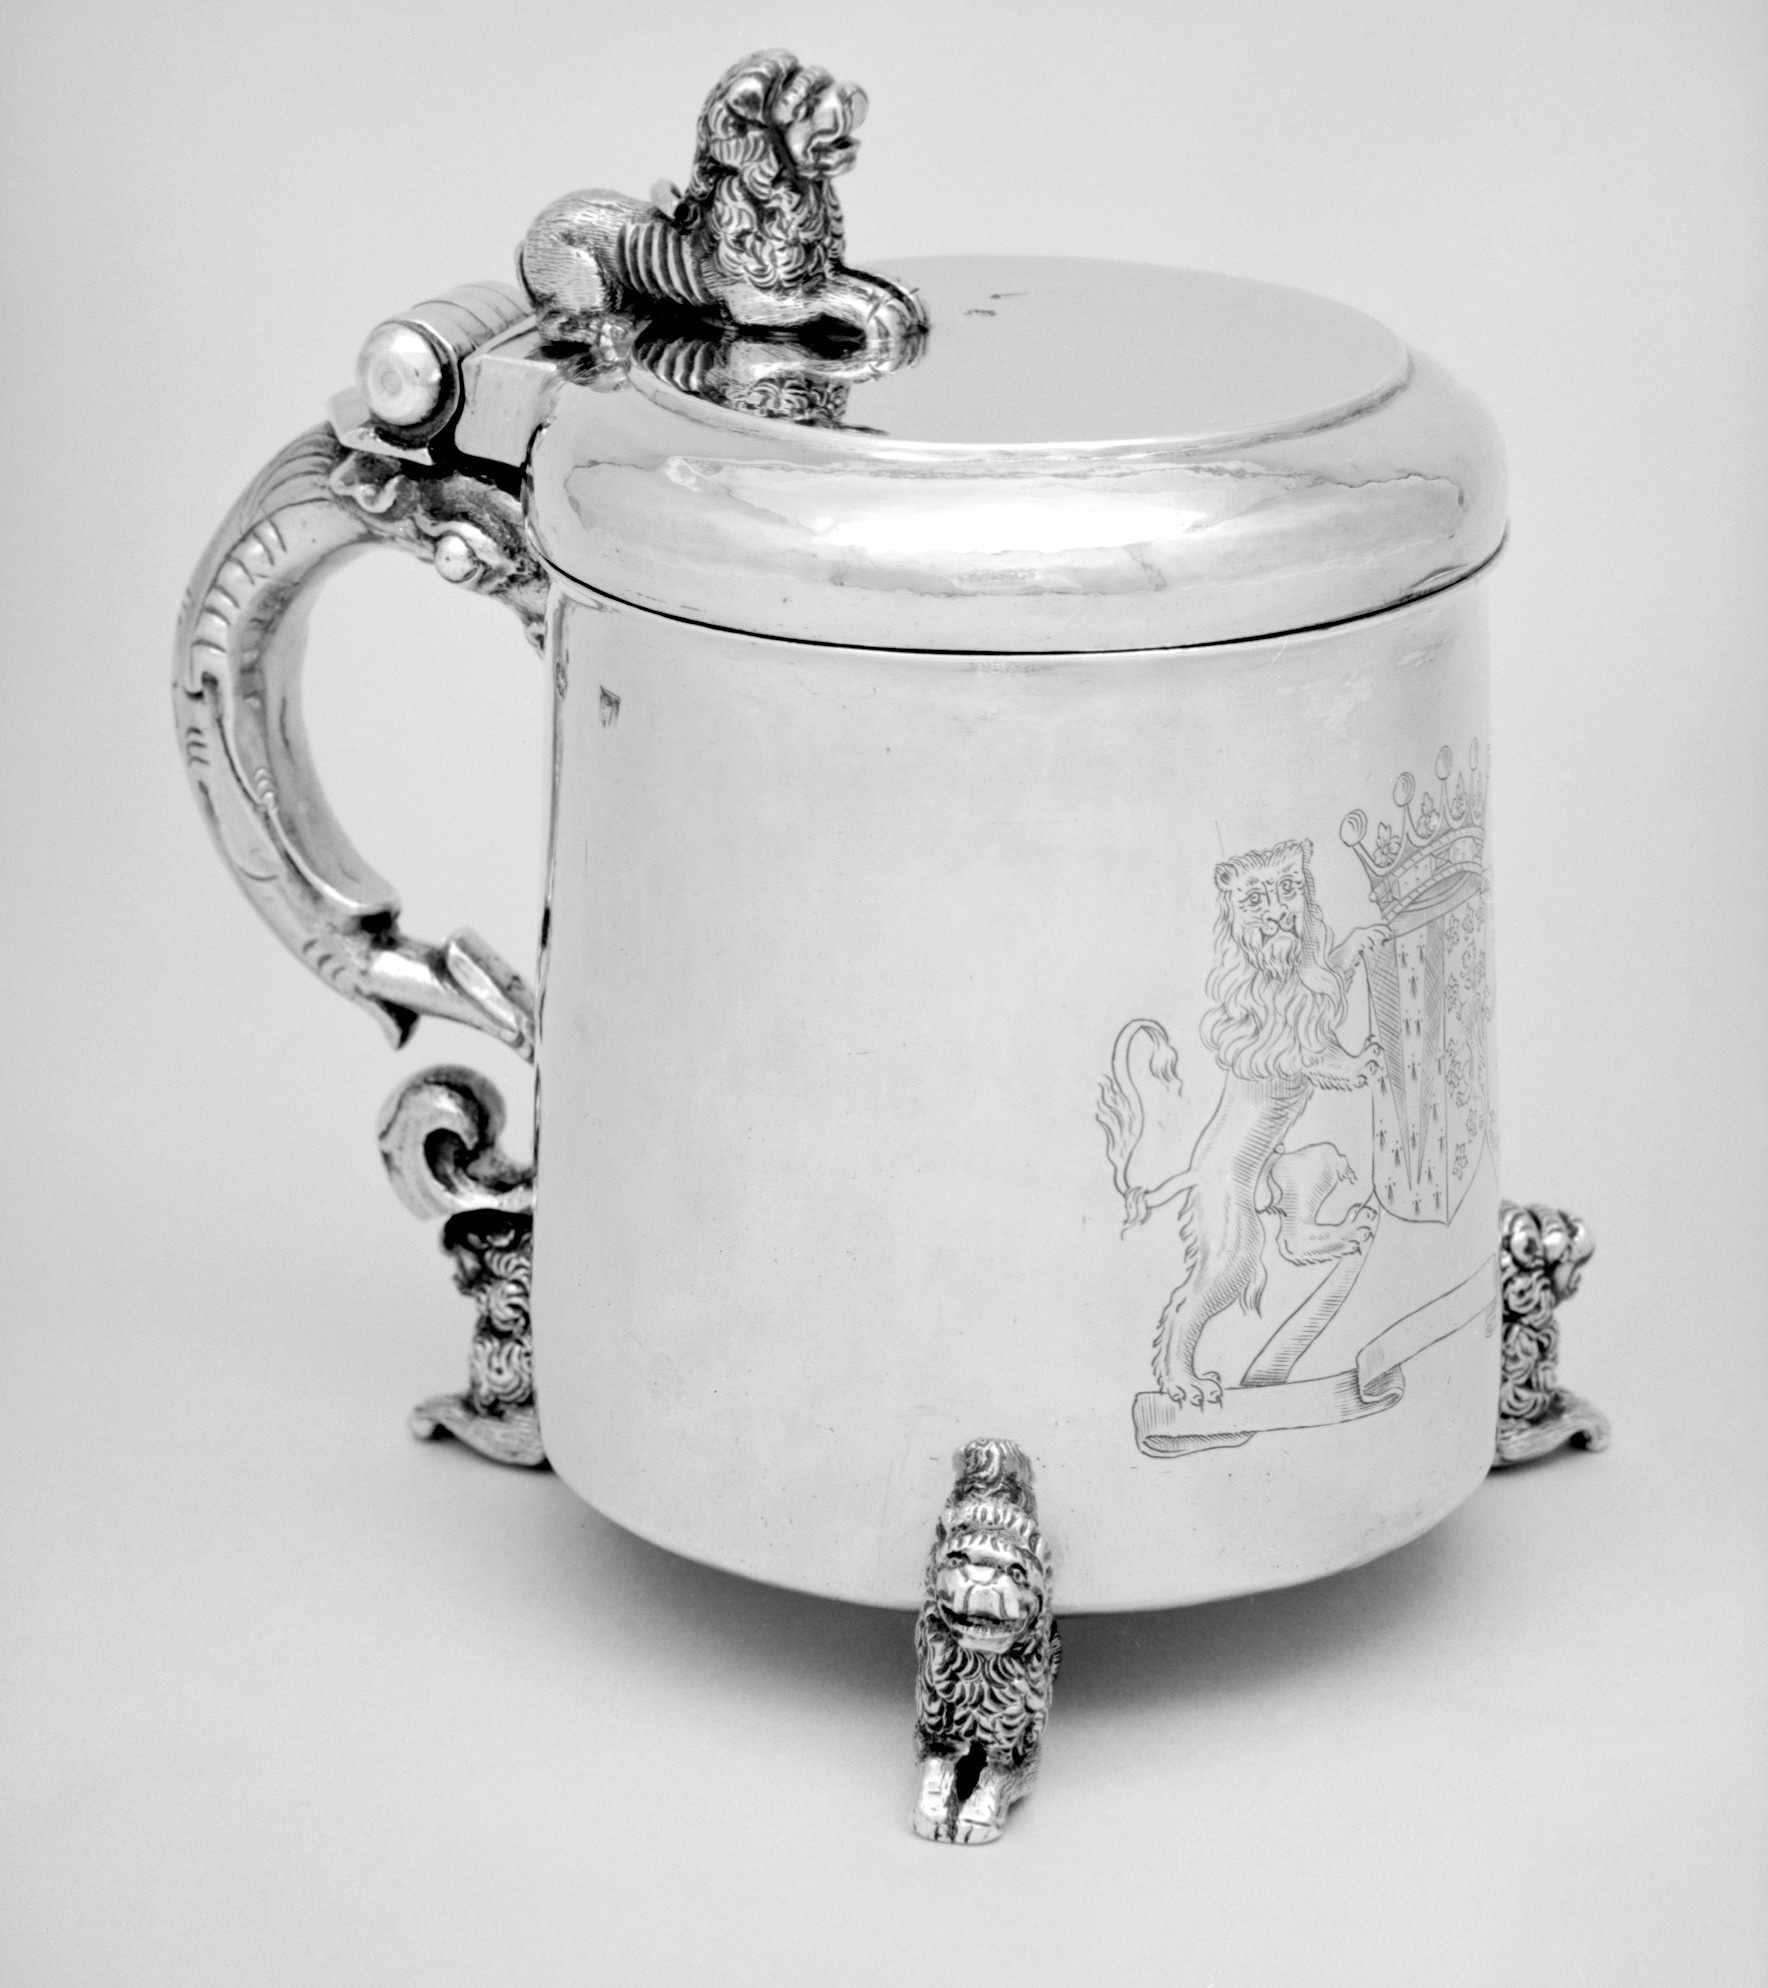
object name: tankard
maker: i. n., london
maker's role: maker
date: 1668-1669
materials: silver gilt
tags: lions,coat of arms